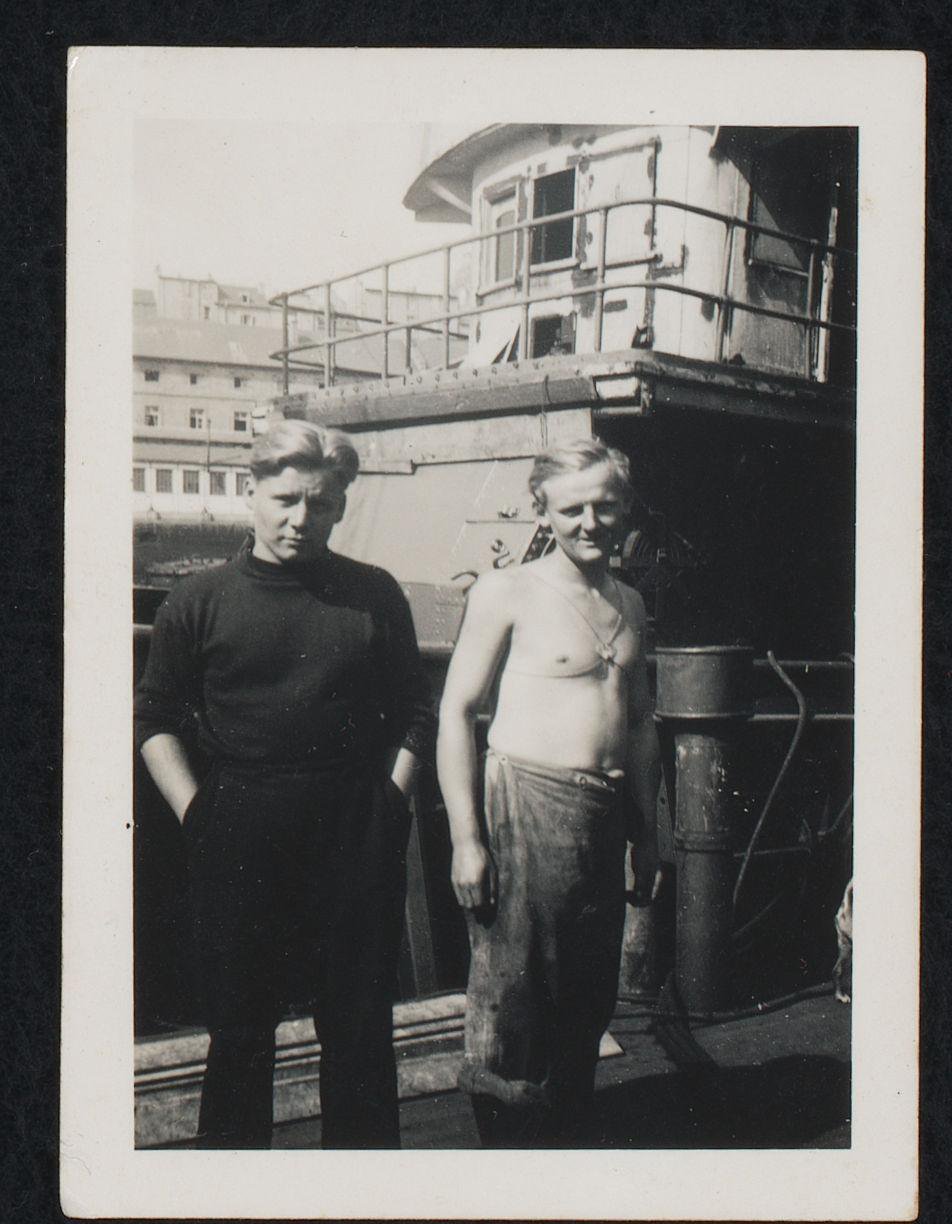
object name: photograph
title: Twee mannen op de kade voor een schip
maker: Anonymous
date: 1940-1943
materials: photographic support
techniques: gelatin silver print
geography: france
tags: the company, the unit, the troop ~ military service, sailor, netherlands, france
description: Twee Duite matrozen staande op de kade voor een schip. Onderdeel van de groep losse foto's behorend bij het fotoalbum over de Kriegsmarine 1940-1943.